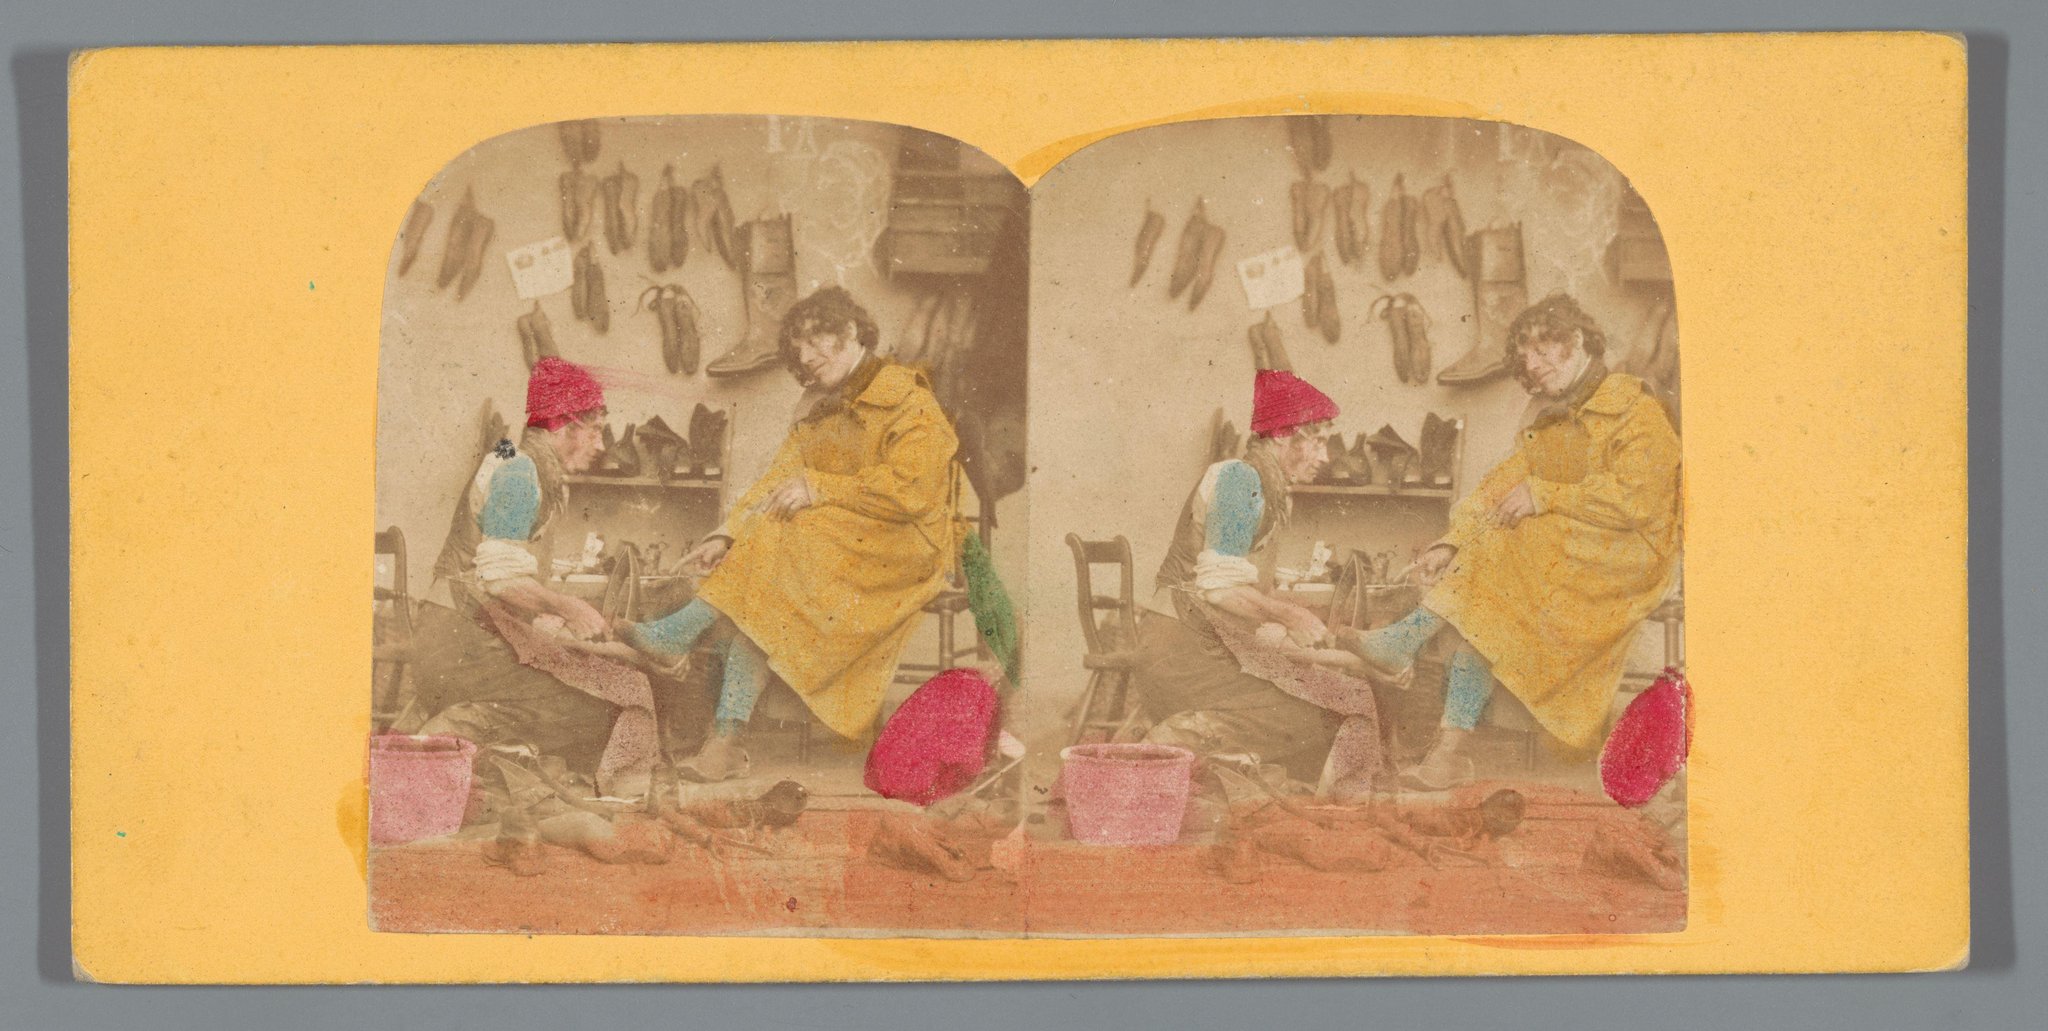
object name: stereograph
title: Man zit bij een schoenmaker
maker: Anonymous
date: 1858-1863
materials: cardboard, paper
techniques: albumen print, hand coloring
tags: shoe-maker, cobbler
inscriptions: inscription: ‘2.50’, inscription: ‘No. 29’